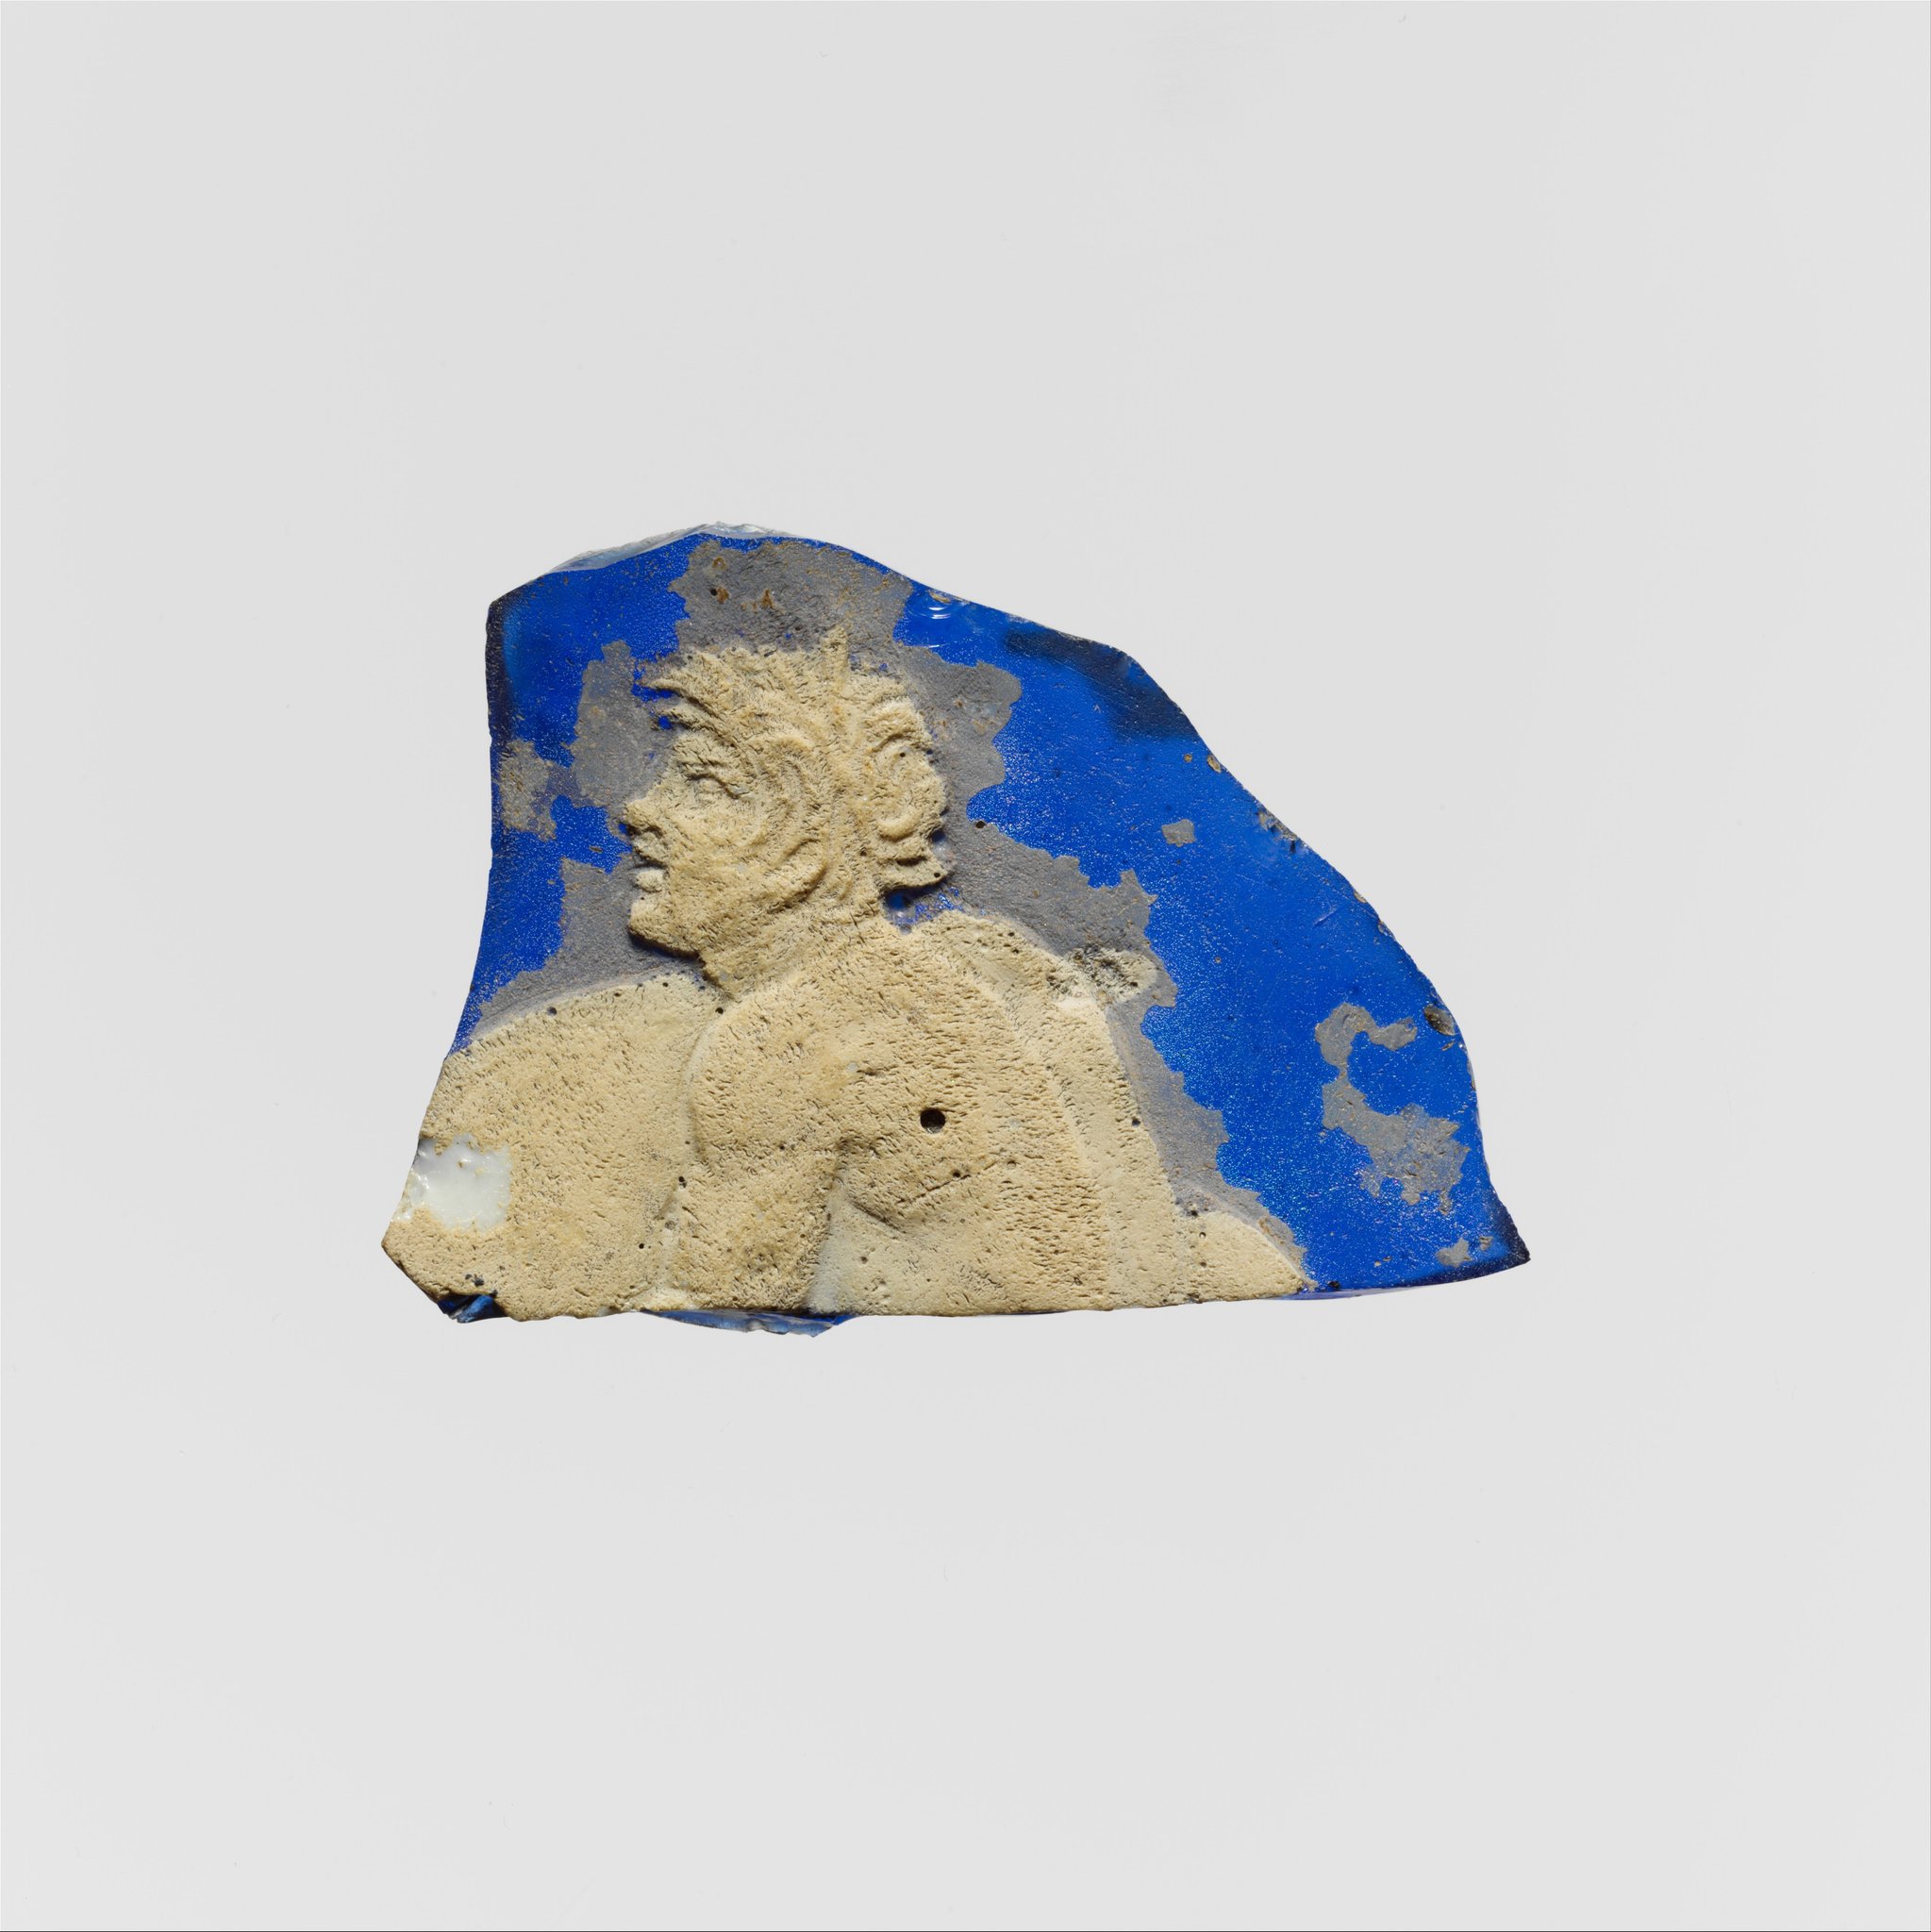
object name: cameo, fragment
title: Cameo glass fragment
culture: roman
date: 1-50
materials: glass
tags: satyrs